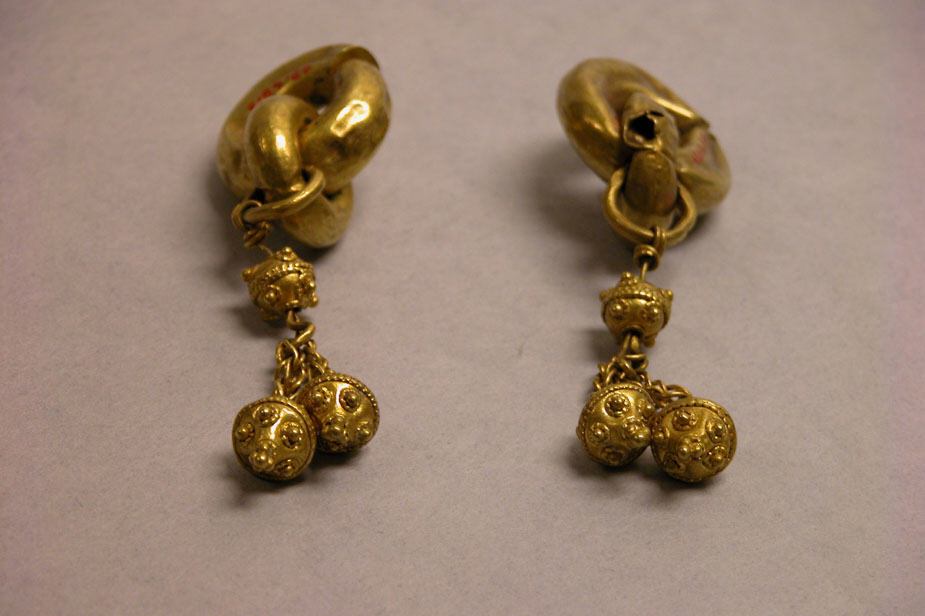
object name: earring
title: Earring (one of a pair)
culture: korean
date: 501-600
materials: gold